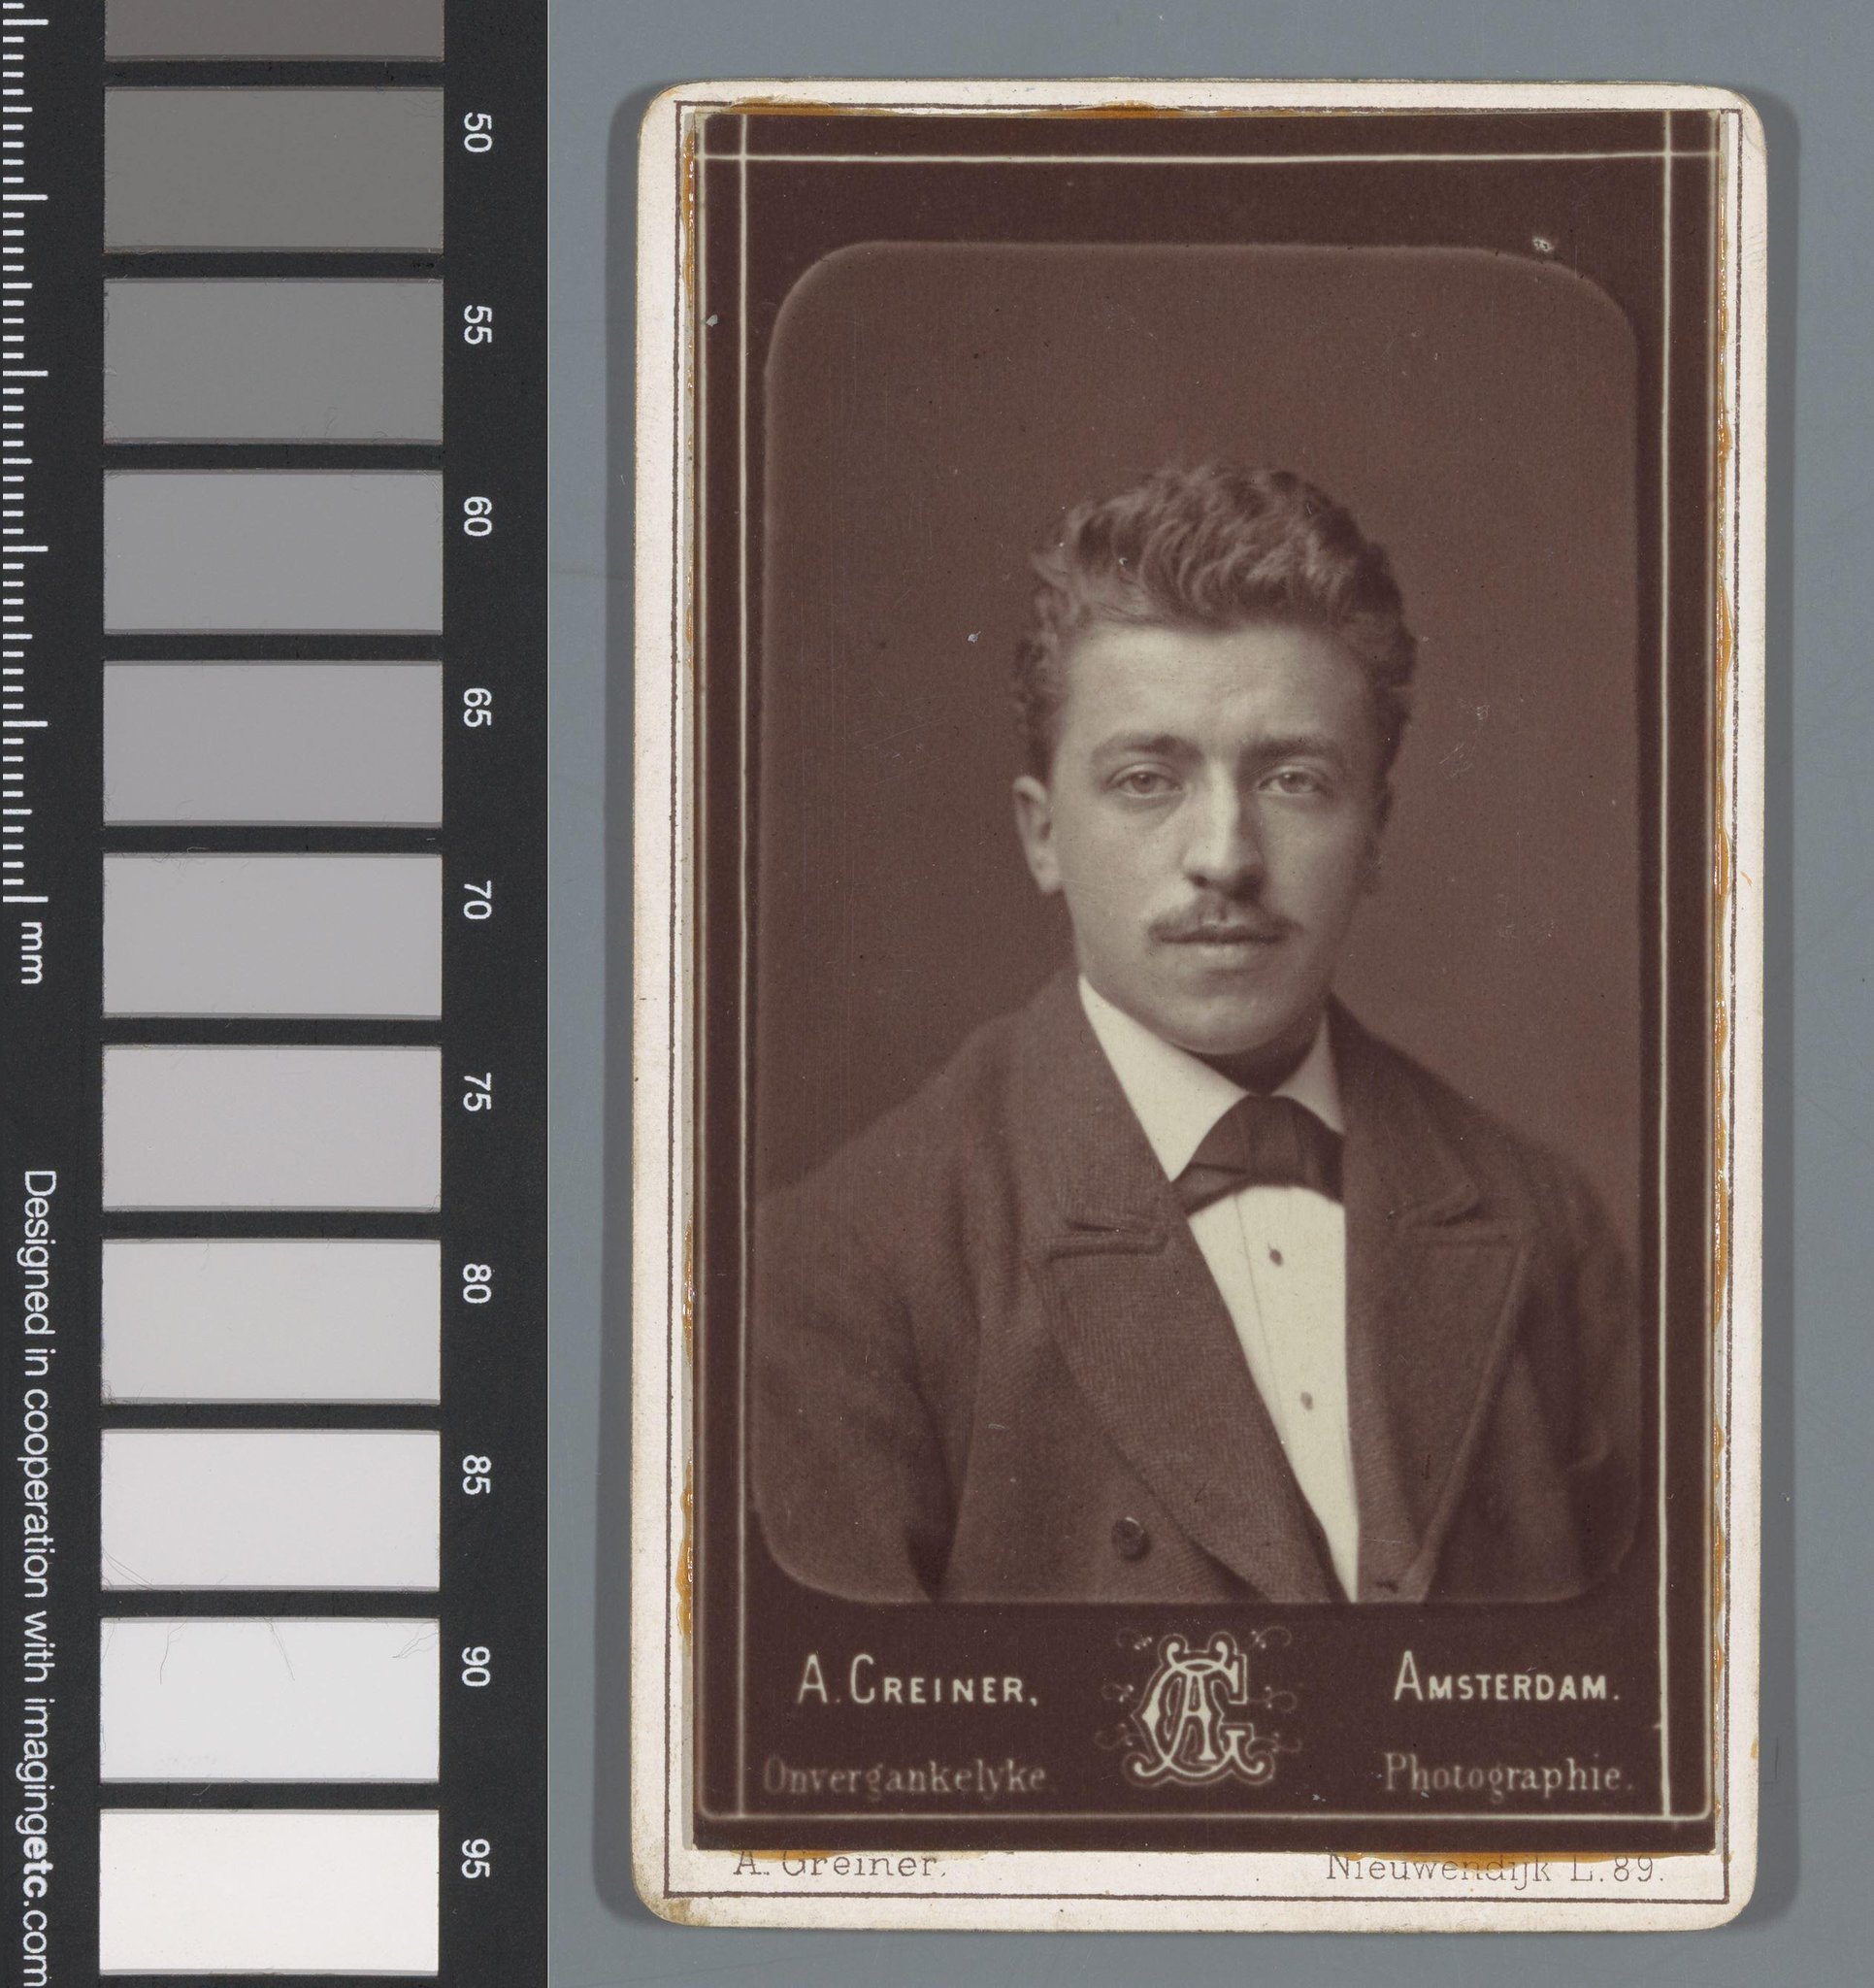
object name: carte de visite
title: Portret van een onbekende man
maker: albert greiner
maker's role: fotograaf, fotostudio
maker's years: 1833-1890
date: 1861-1874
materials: cardboard, celluloid, paper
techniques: albumen print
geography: amsterdam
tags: adult man, historical persons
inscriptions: inscription: ‘AG/ A. GREINER/ Photograf/ AMSTERDAM/ NIEUWENDIJK L. 89’, inscription: ‘AG/ A. GREINER AMSTERDAM./ Onvergankelyke Photographie’, stamp: ‘ONVERANDERLYKE KOOLDRUK’, inscription: ‘A. Greiner Nieuwendijk L. 89’